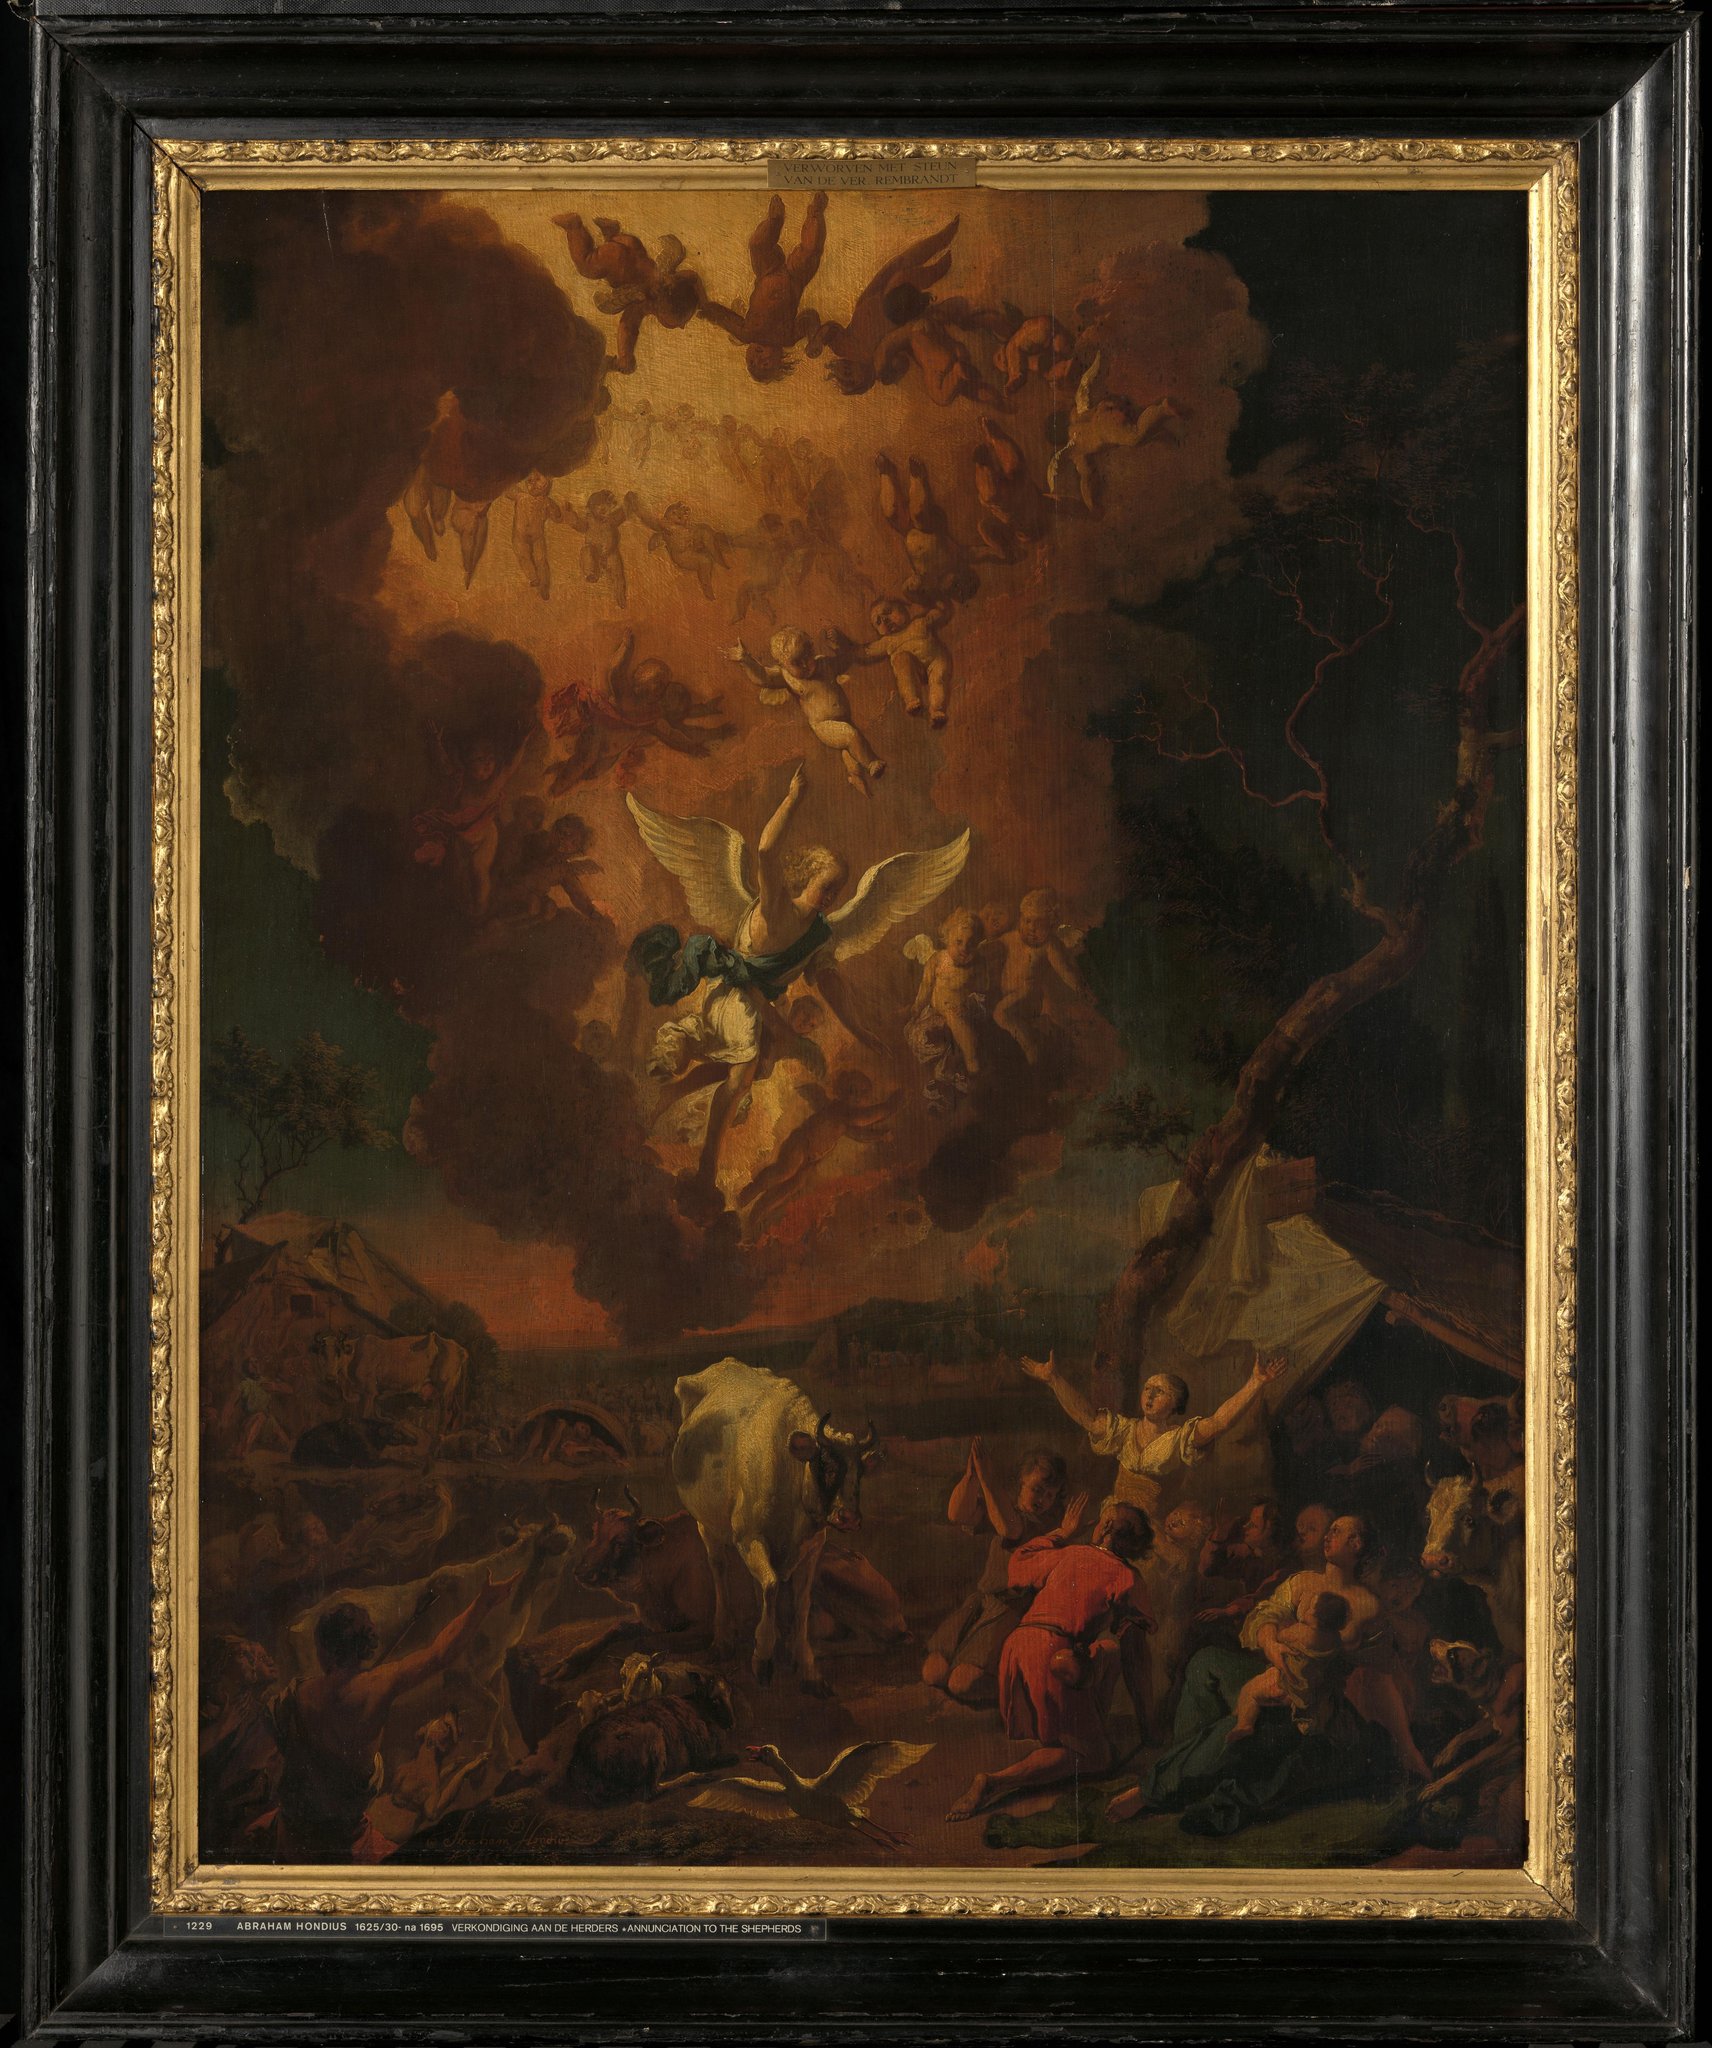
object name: frame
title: Zwart geverfde profiellijst lijst met langs de dagkant een rand verguld pâte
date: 1400-1950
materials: wood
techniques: gilding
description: Zwart geverfde profiellijst lijst met langs de dagkant een rand verguld pâte met een geornamenteerd randje en een glad randje langs de dagkant.